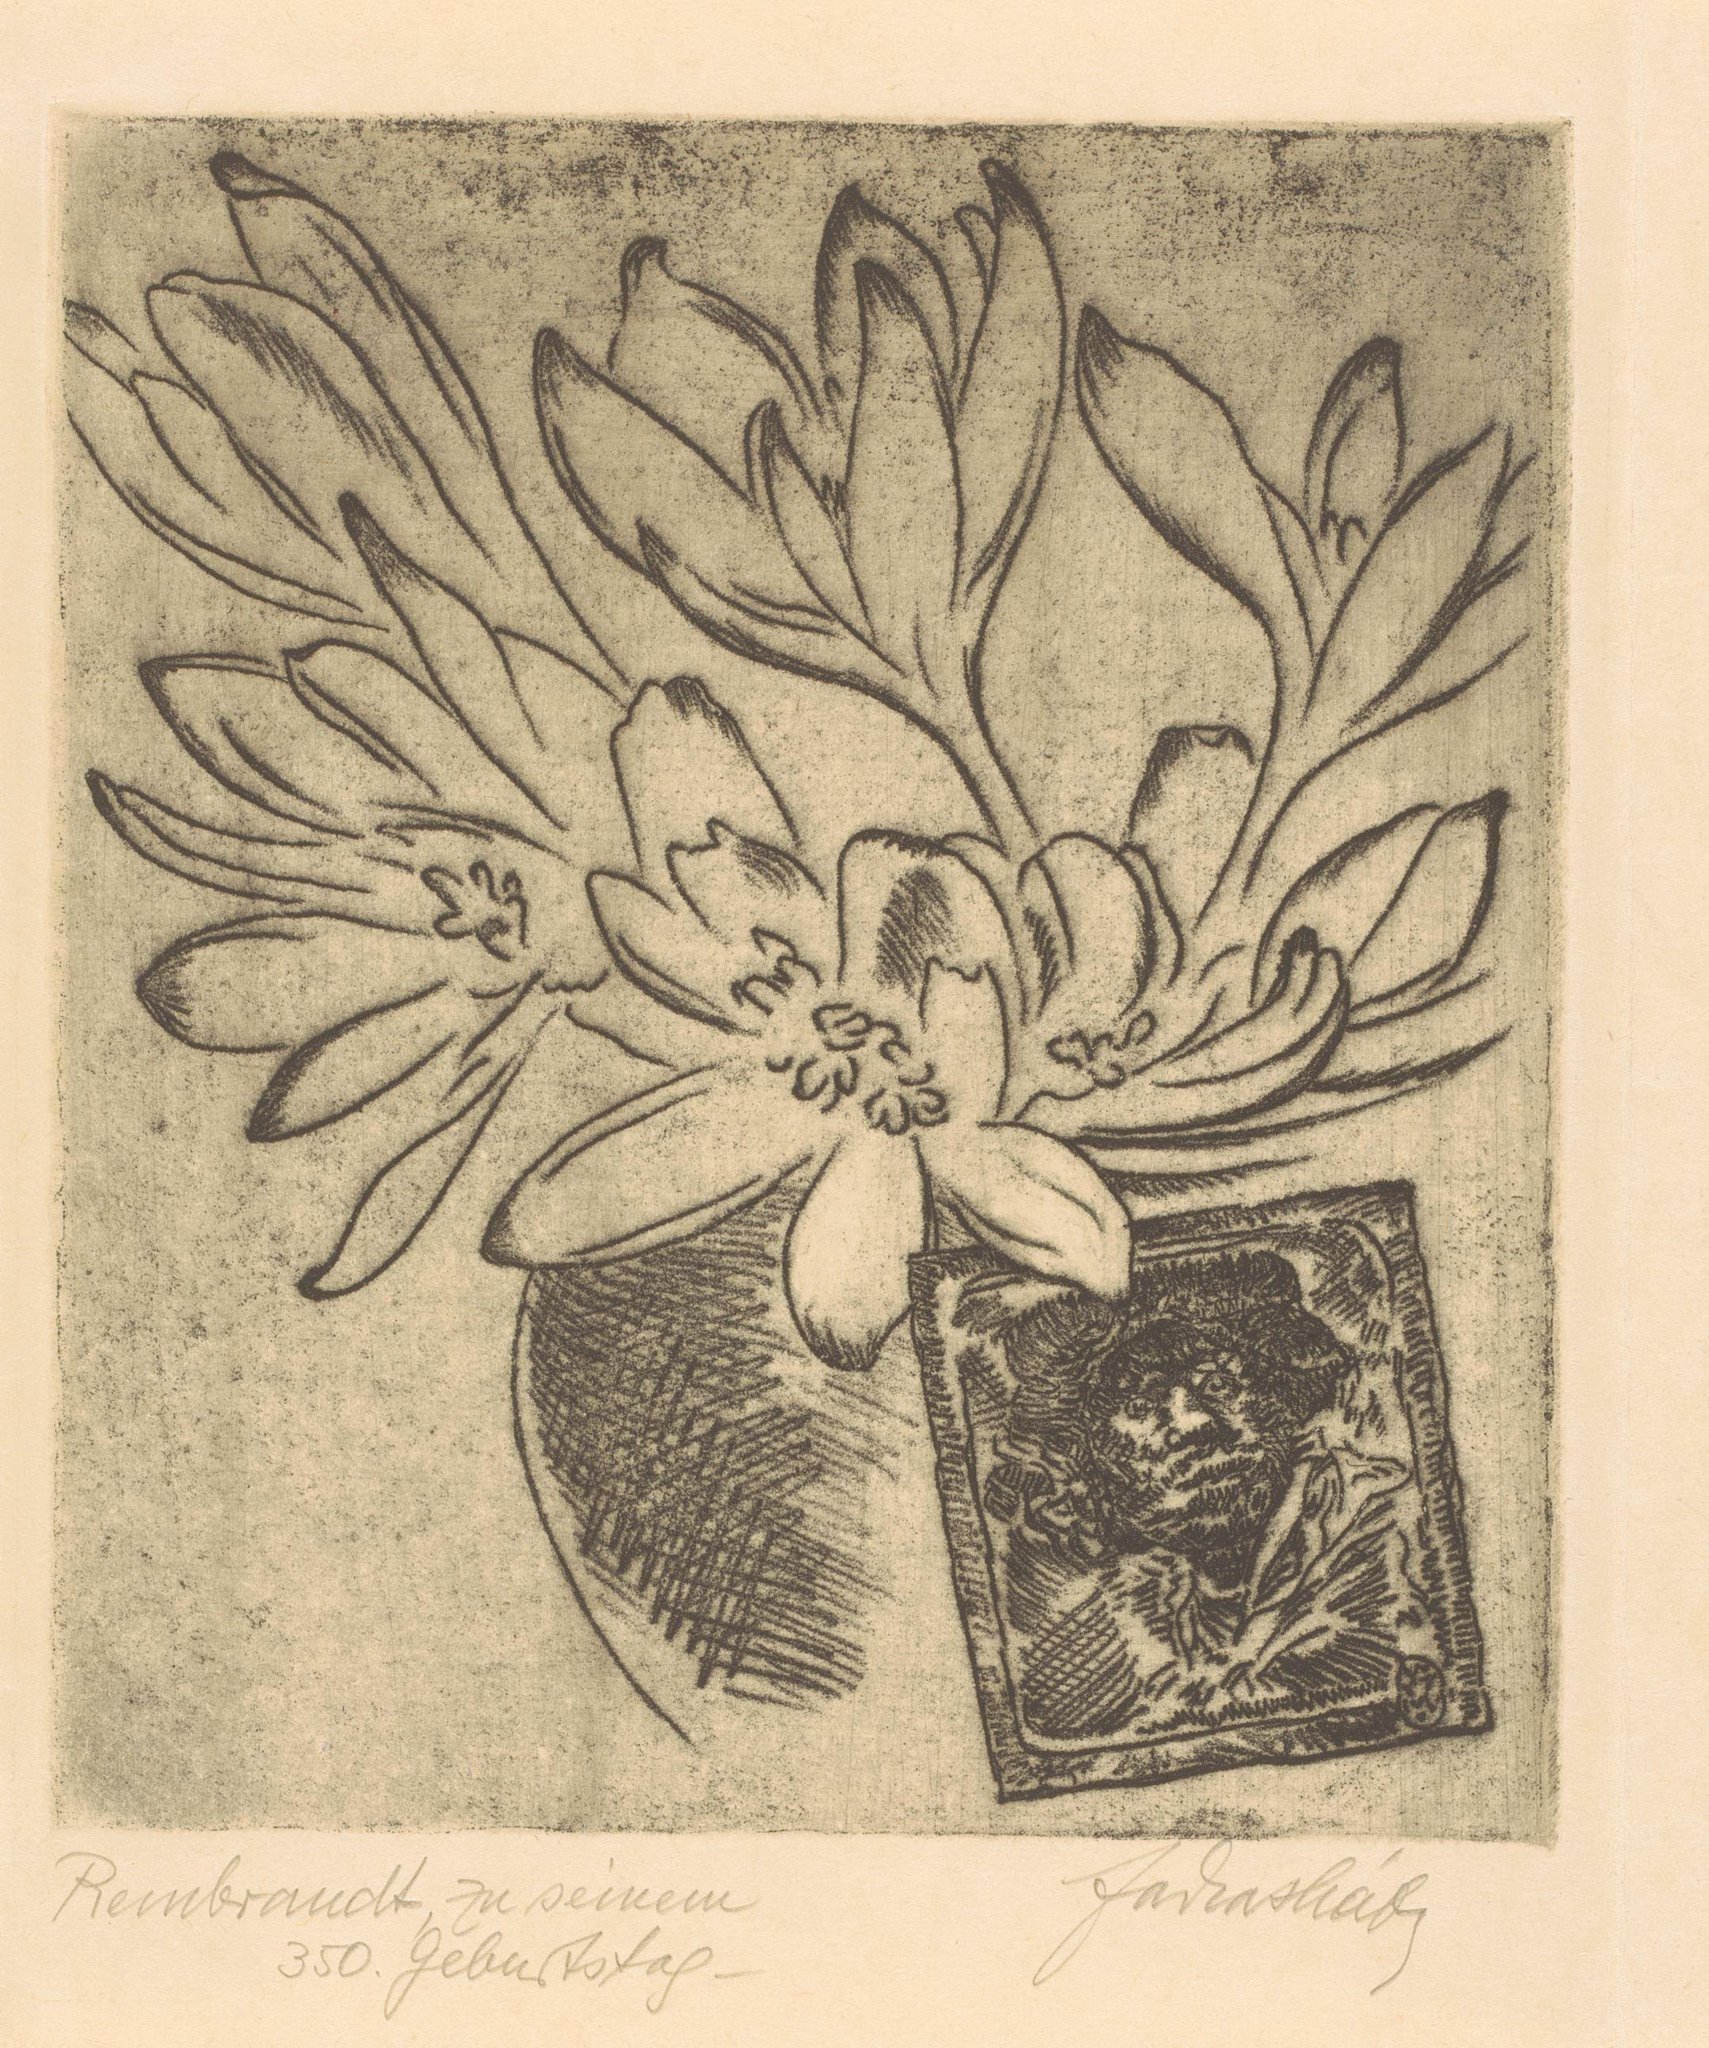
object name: print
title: Rembrandt zu seinem 350 Geburtstag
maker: nikolaus farkashazy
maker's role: print maker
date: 1956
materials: paper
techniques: intaglio, soft ground etching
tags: leiden, amsterdam, painter, print maker, draughtsman, rembrandt van rijn, historical persons, flowers in a vase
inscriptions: collector's mark: Lugt 2228, annotation: ‘Dem Direktor des Rijksmuseums in Amsterdam’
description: Vaas met bloemen met daaronder een portret van Rembrandt.